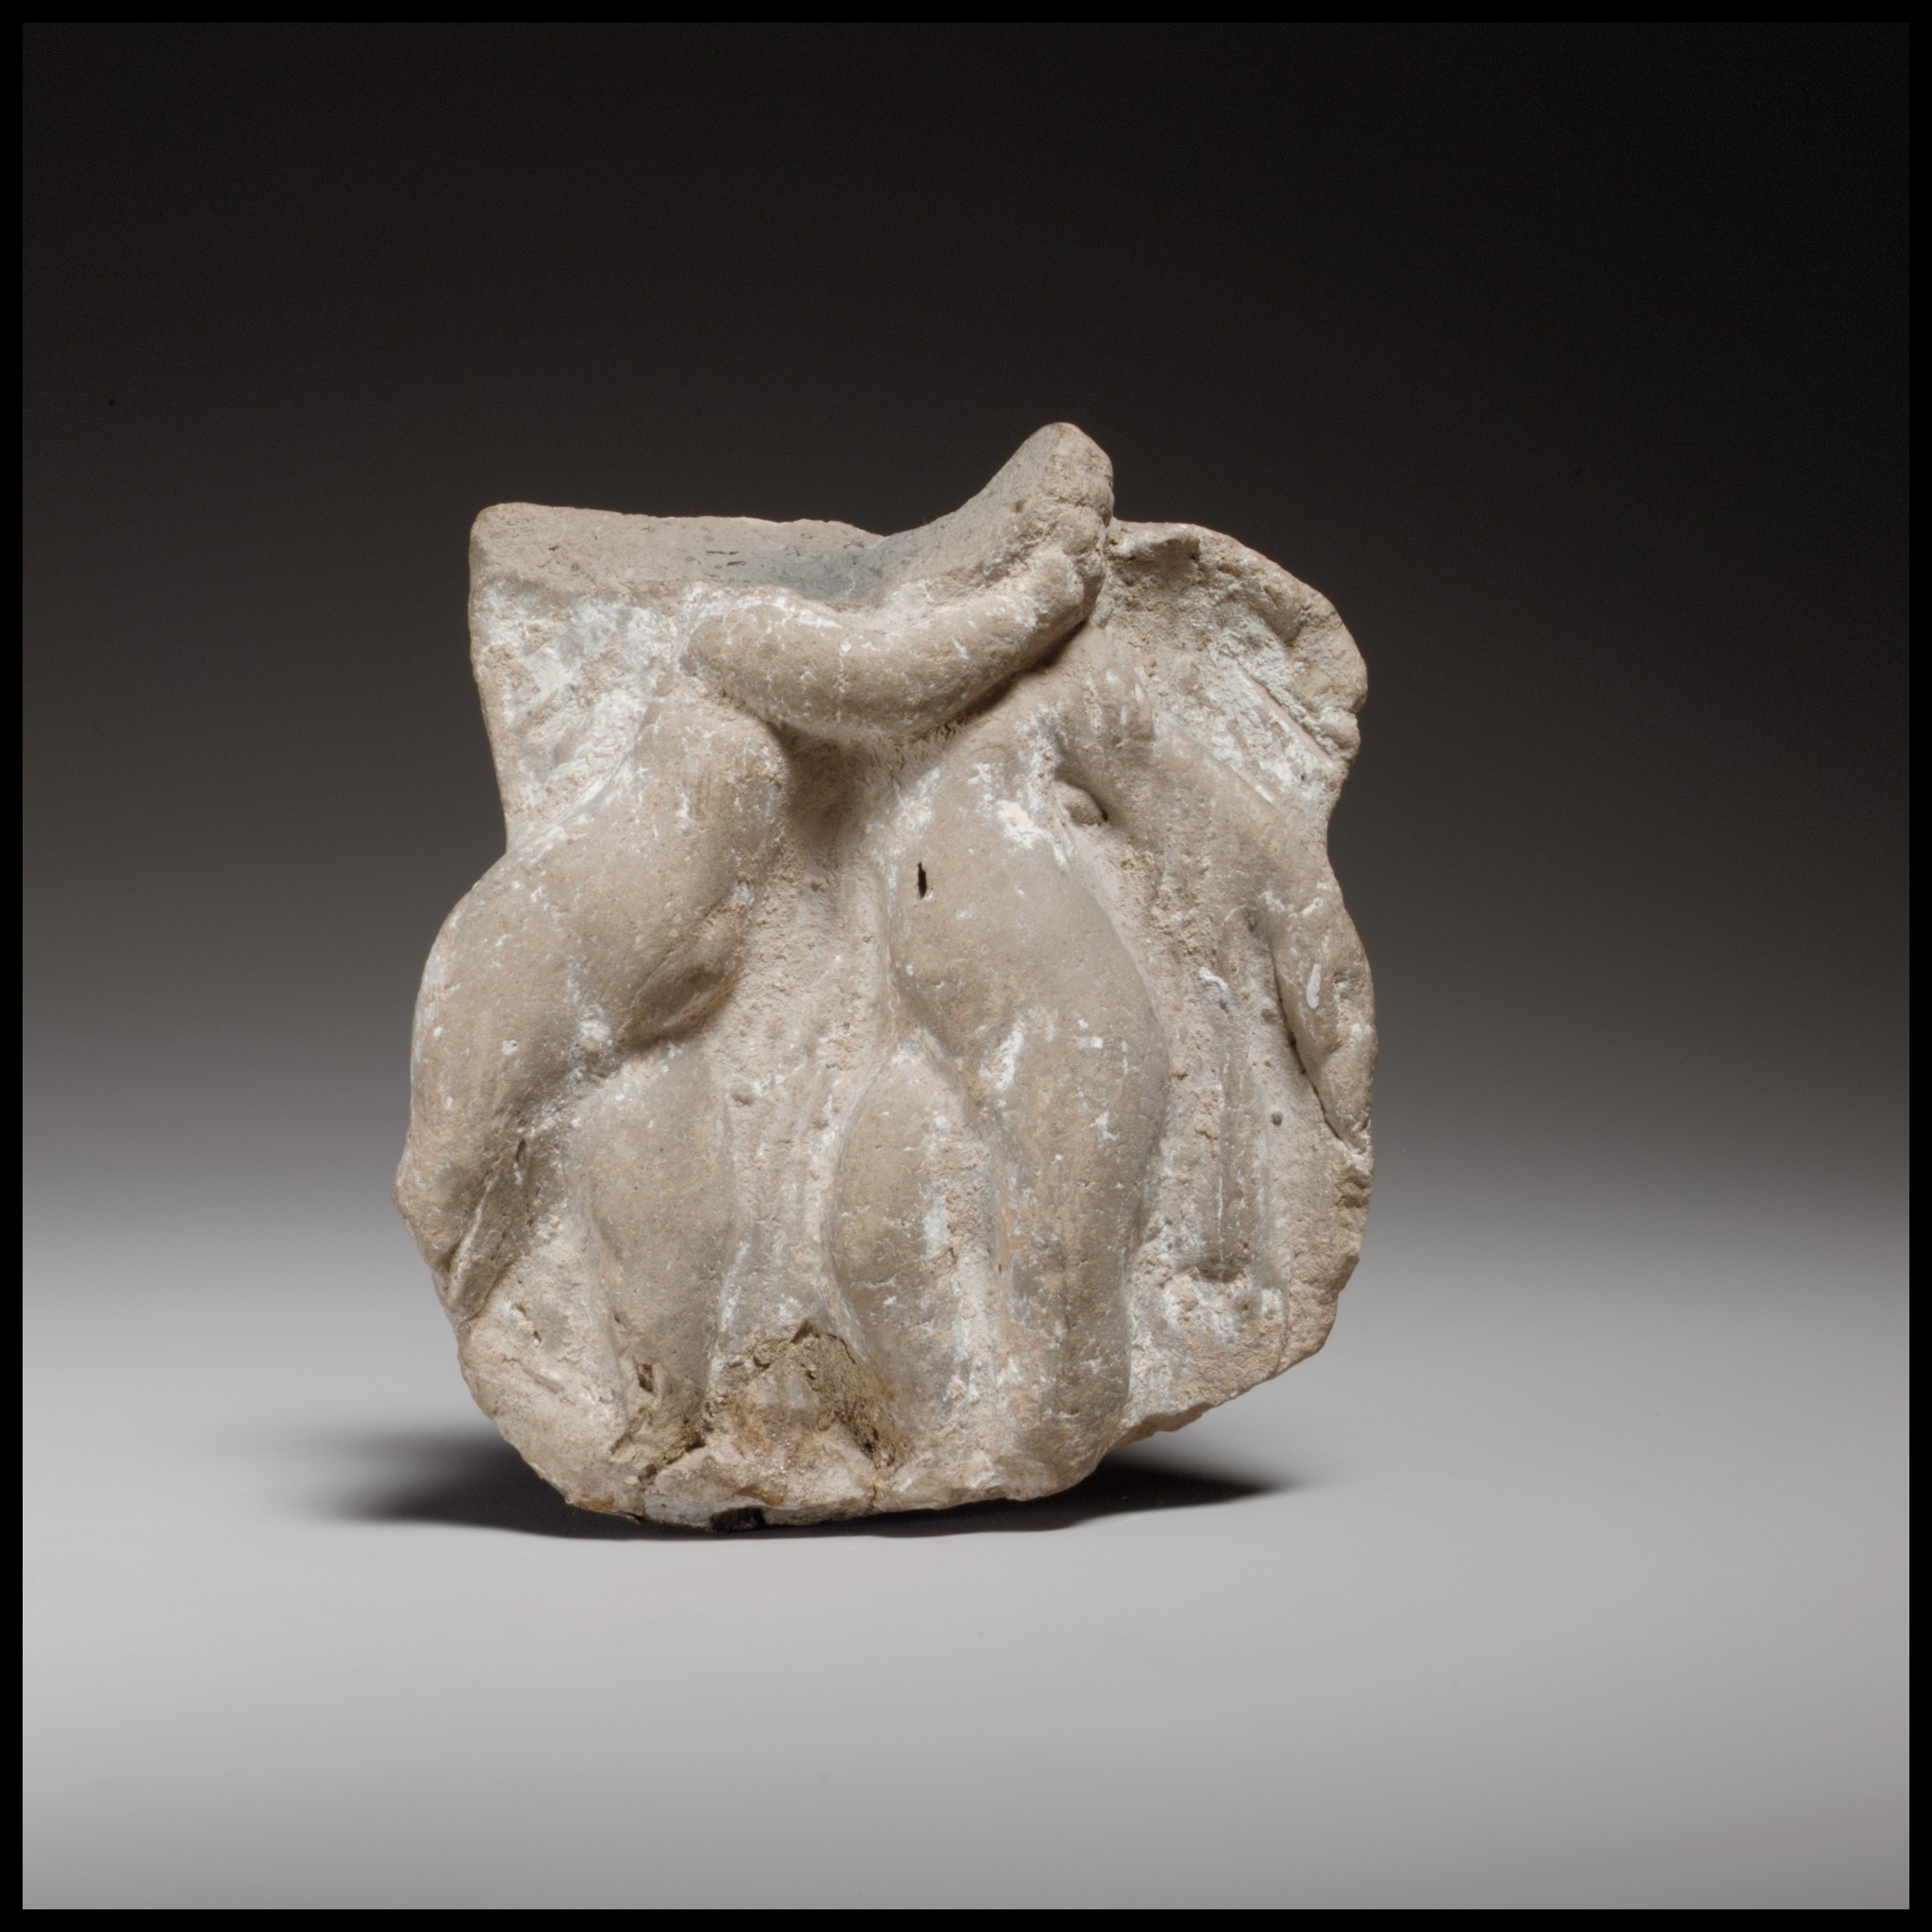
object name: relief of eros and psyche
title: Relief depicting Eros and Psyche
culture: cypriot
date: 200-1 BCE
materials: terracotta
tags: eros,psyche